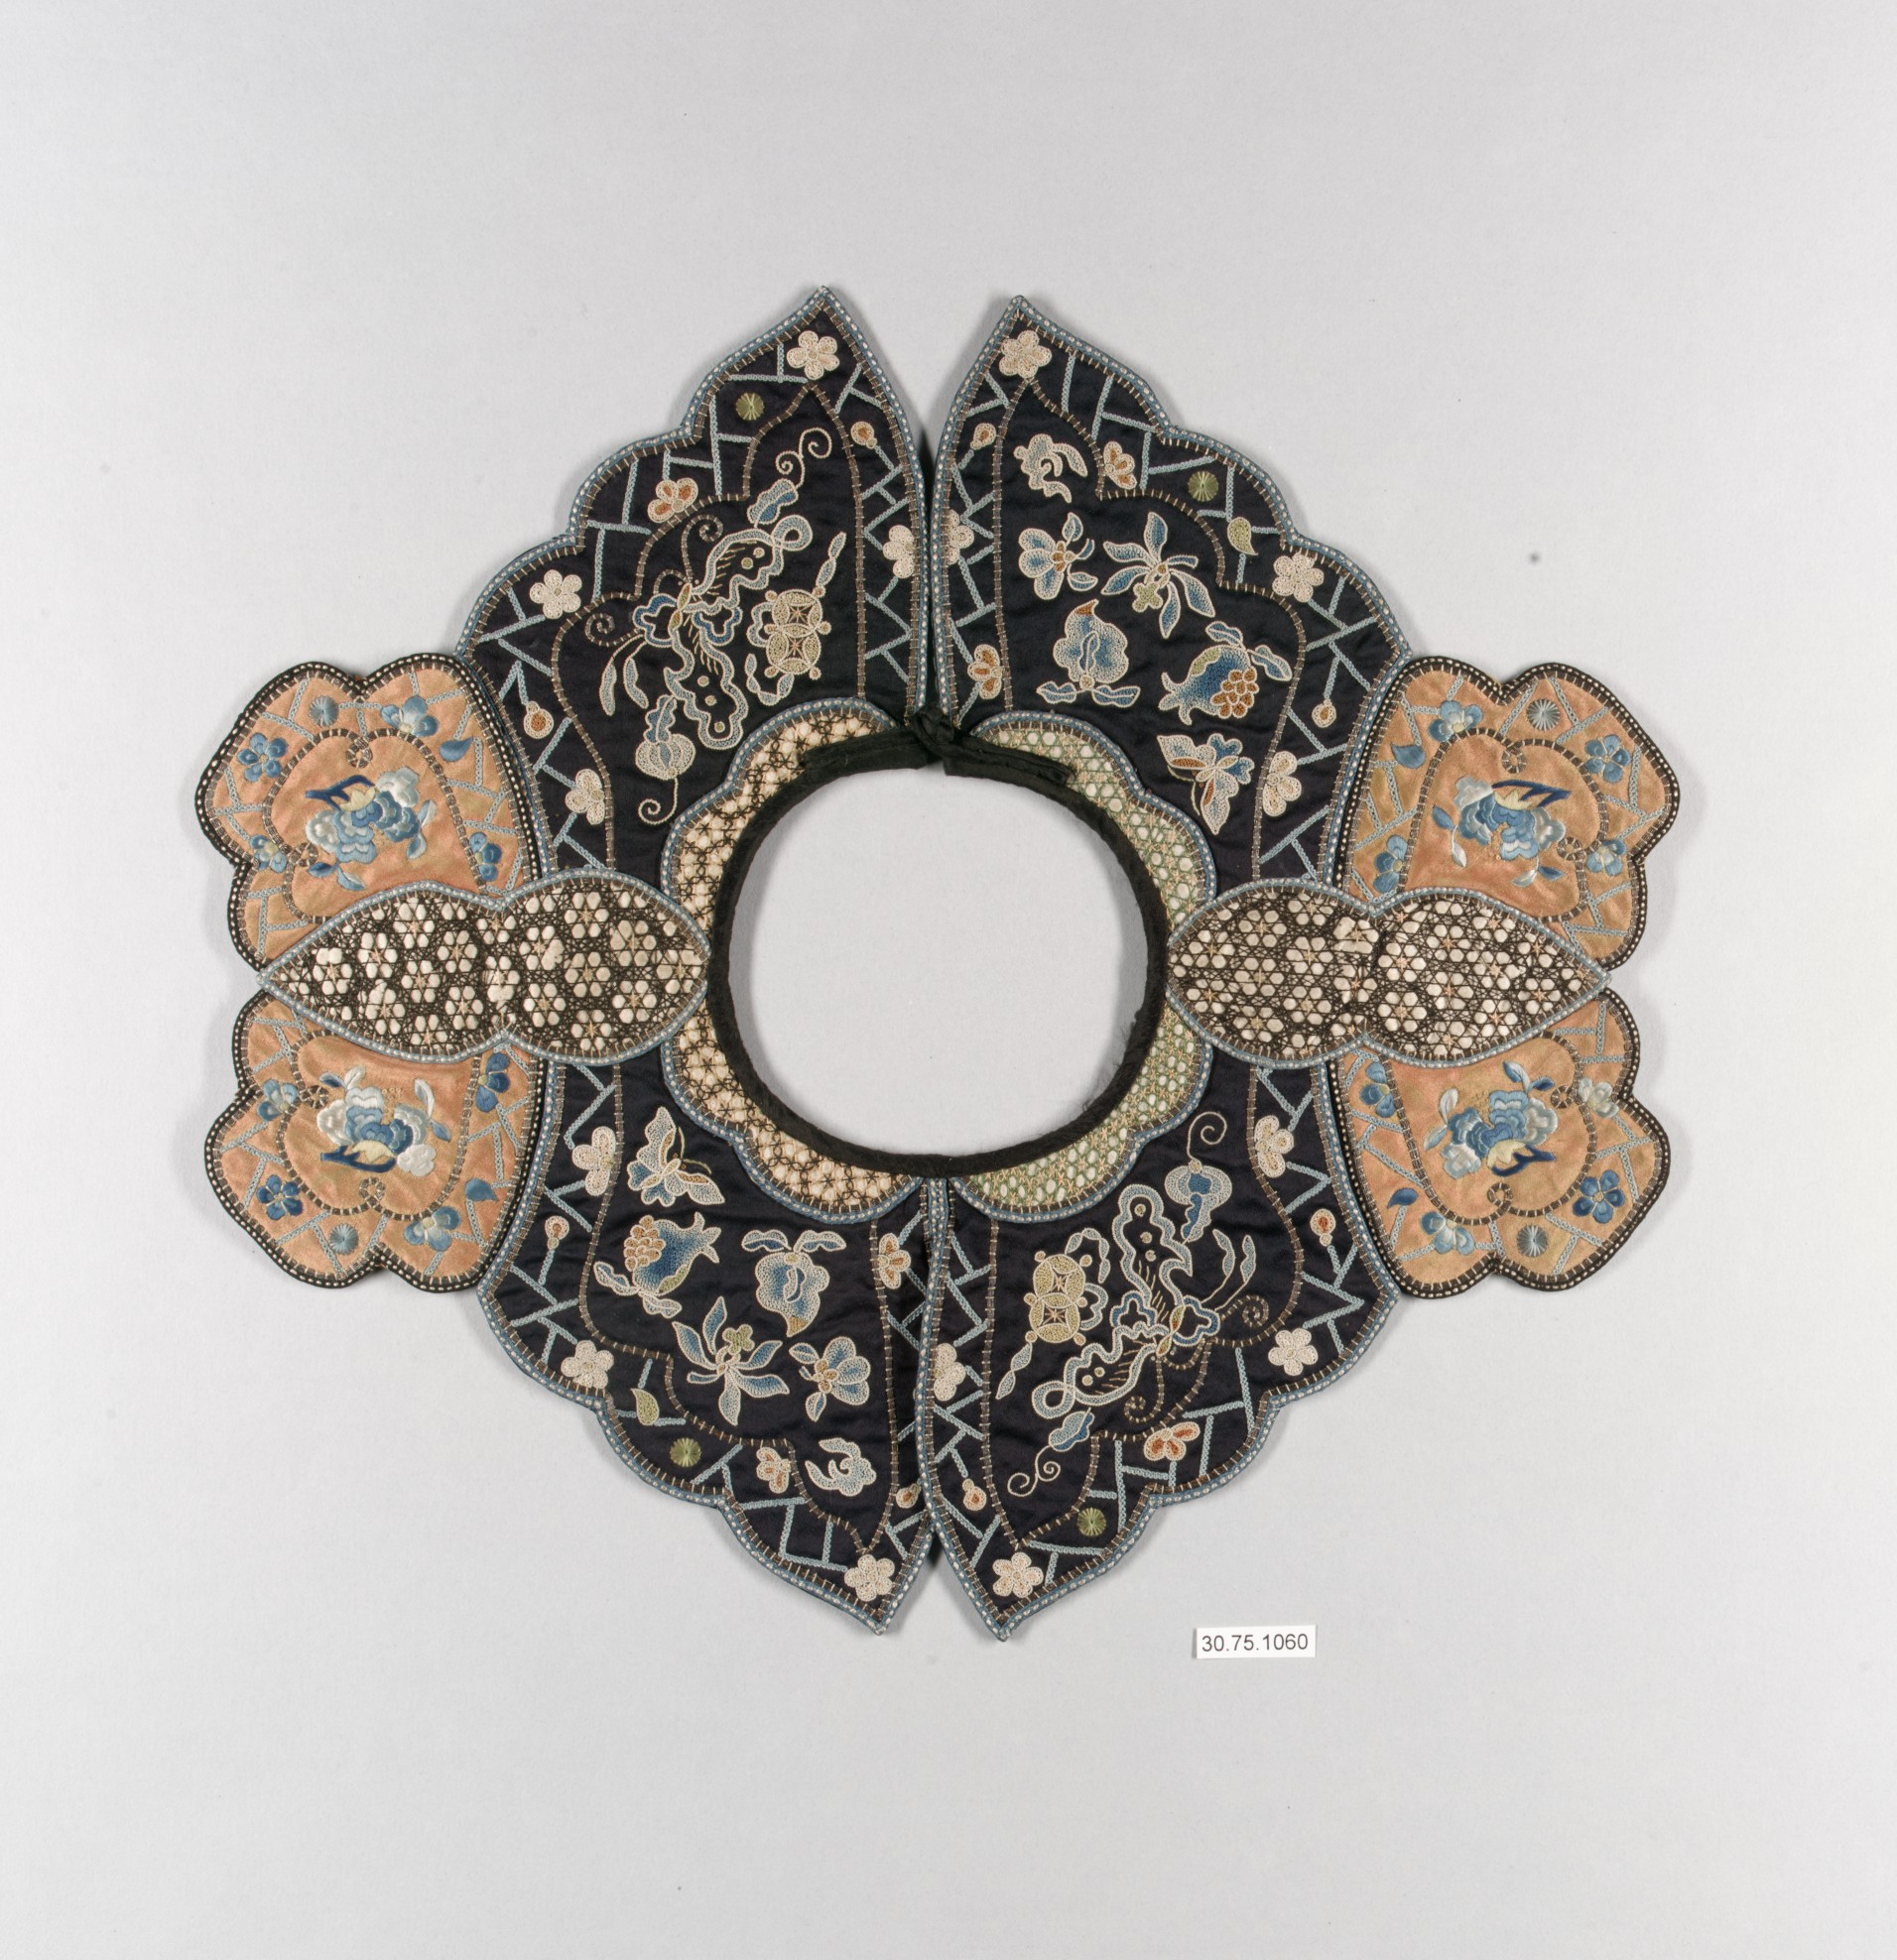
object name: collar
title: Collar in the Shape of Two Butterflies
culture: chinese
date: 1701-1900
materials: silk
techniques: embroidery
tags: flowers